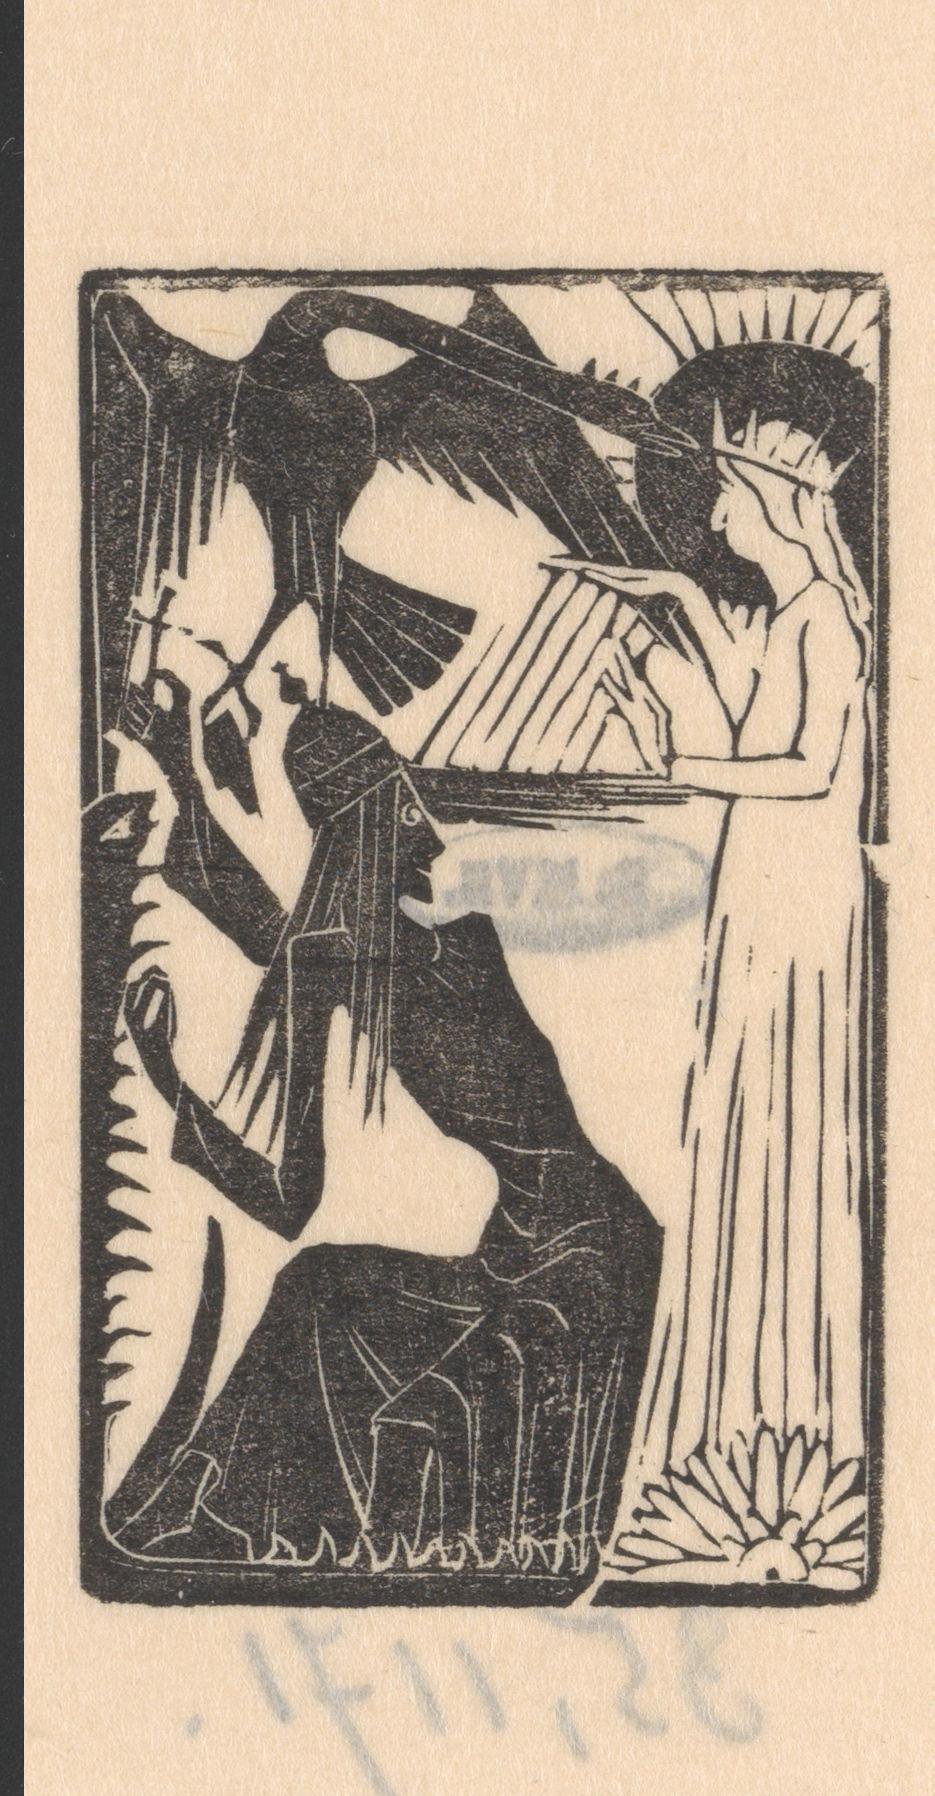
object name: illustration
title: Twee vrouwen en een vogel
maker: mathieu lauweriks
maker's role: designer, draughtsman, print maker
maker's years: 1864-1932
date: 1895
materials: paper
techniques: woodcut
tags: mouth wide open, water-birds: goose, water-birds: swan, insignia of the pope, e.g. tiara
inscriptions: collector's mark: Lugt 2228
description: Een knielende vrouw in de muil van een monster met in haar hand een kruis en op haar hoofd een pauselijke tiara. Boven haar hoofd vliegt een vogel, mogelijk een gans of een zwaan. Naast haar staat een in het wit geklede vrouw op een bloem.